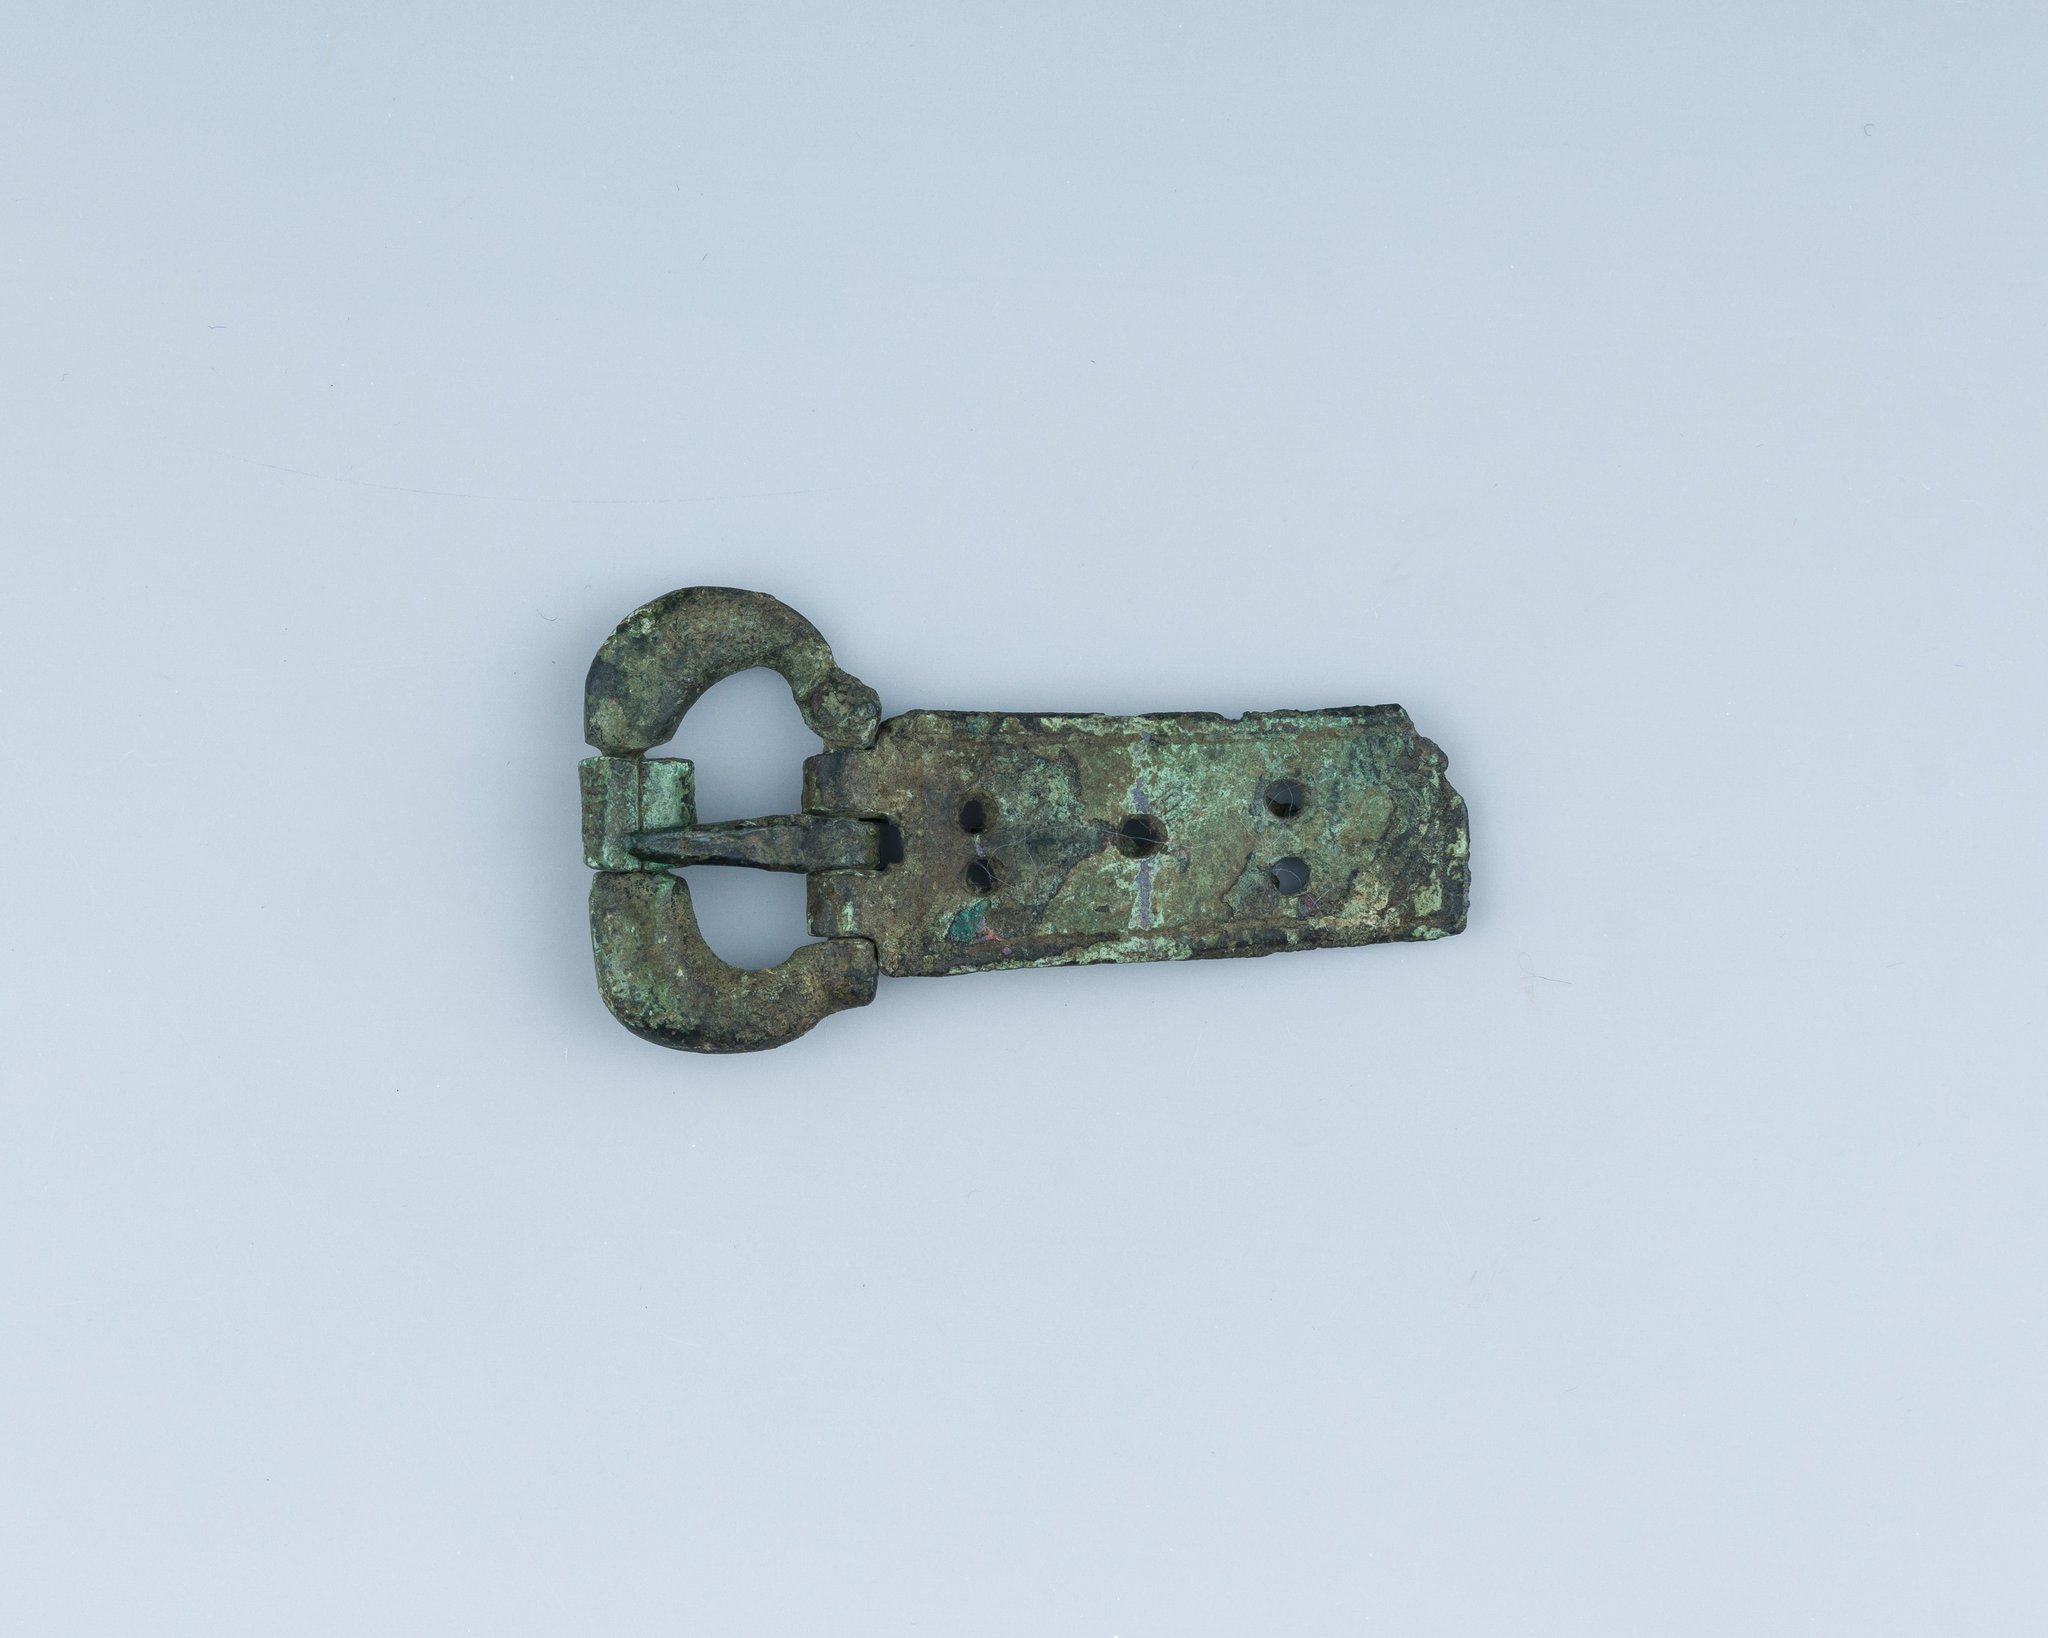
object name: buckle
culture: european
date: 1401-1600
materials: bronze, patina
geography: germany